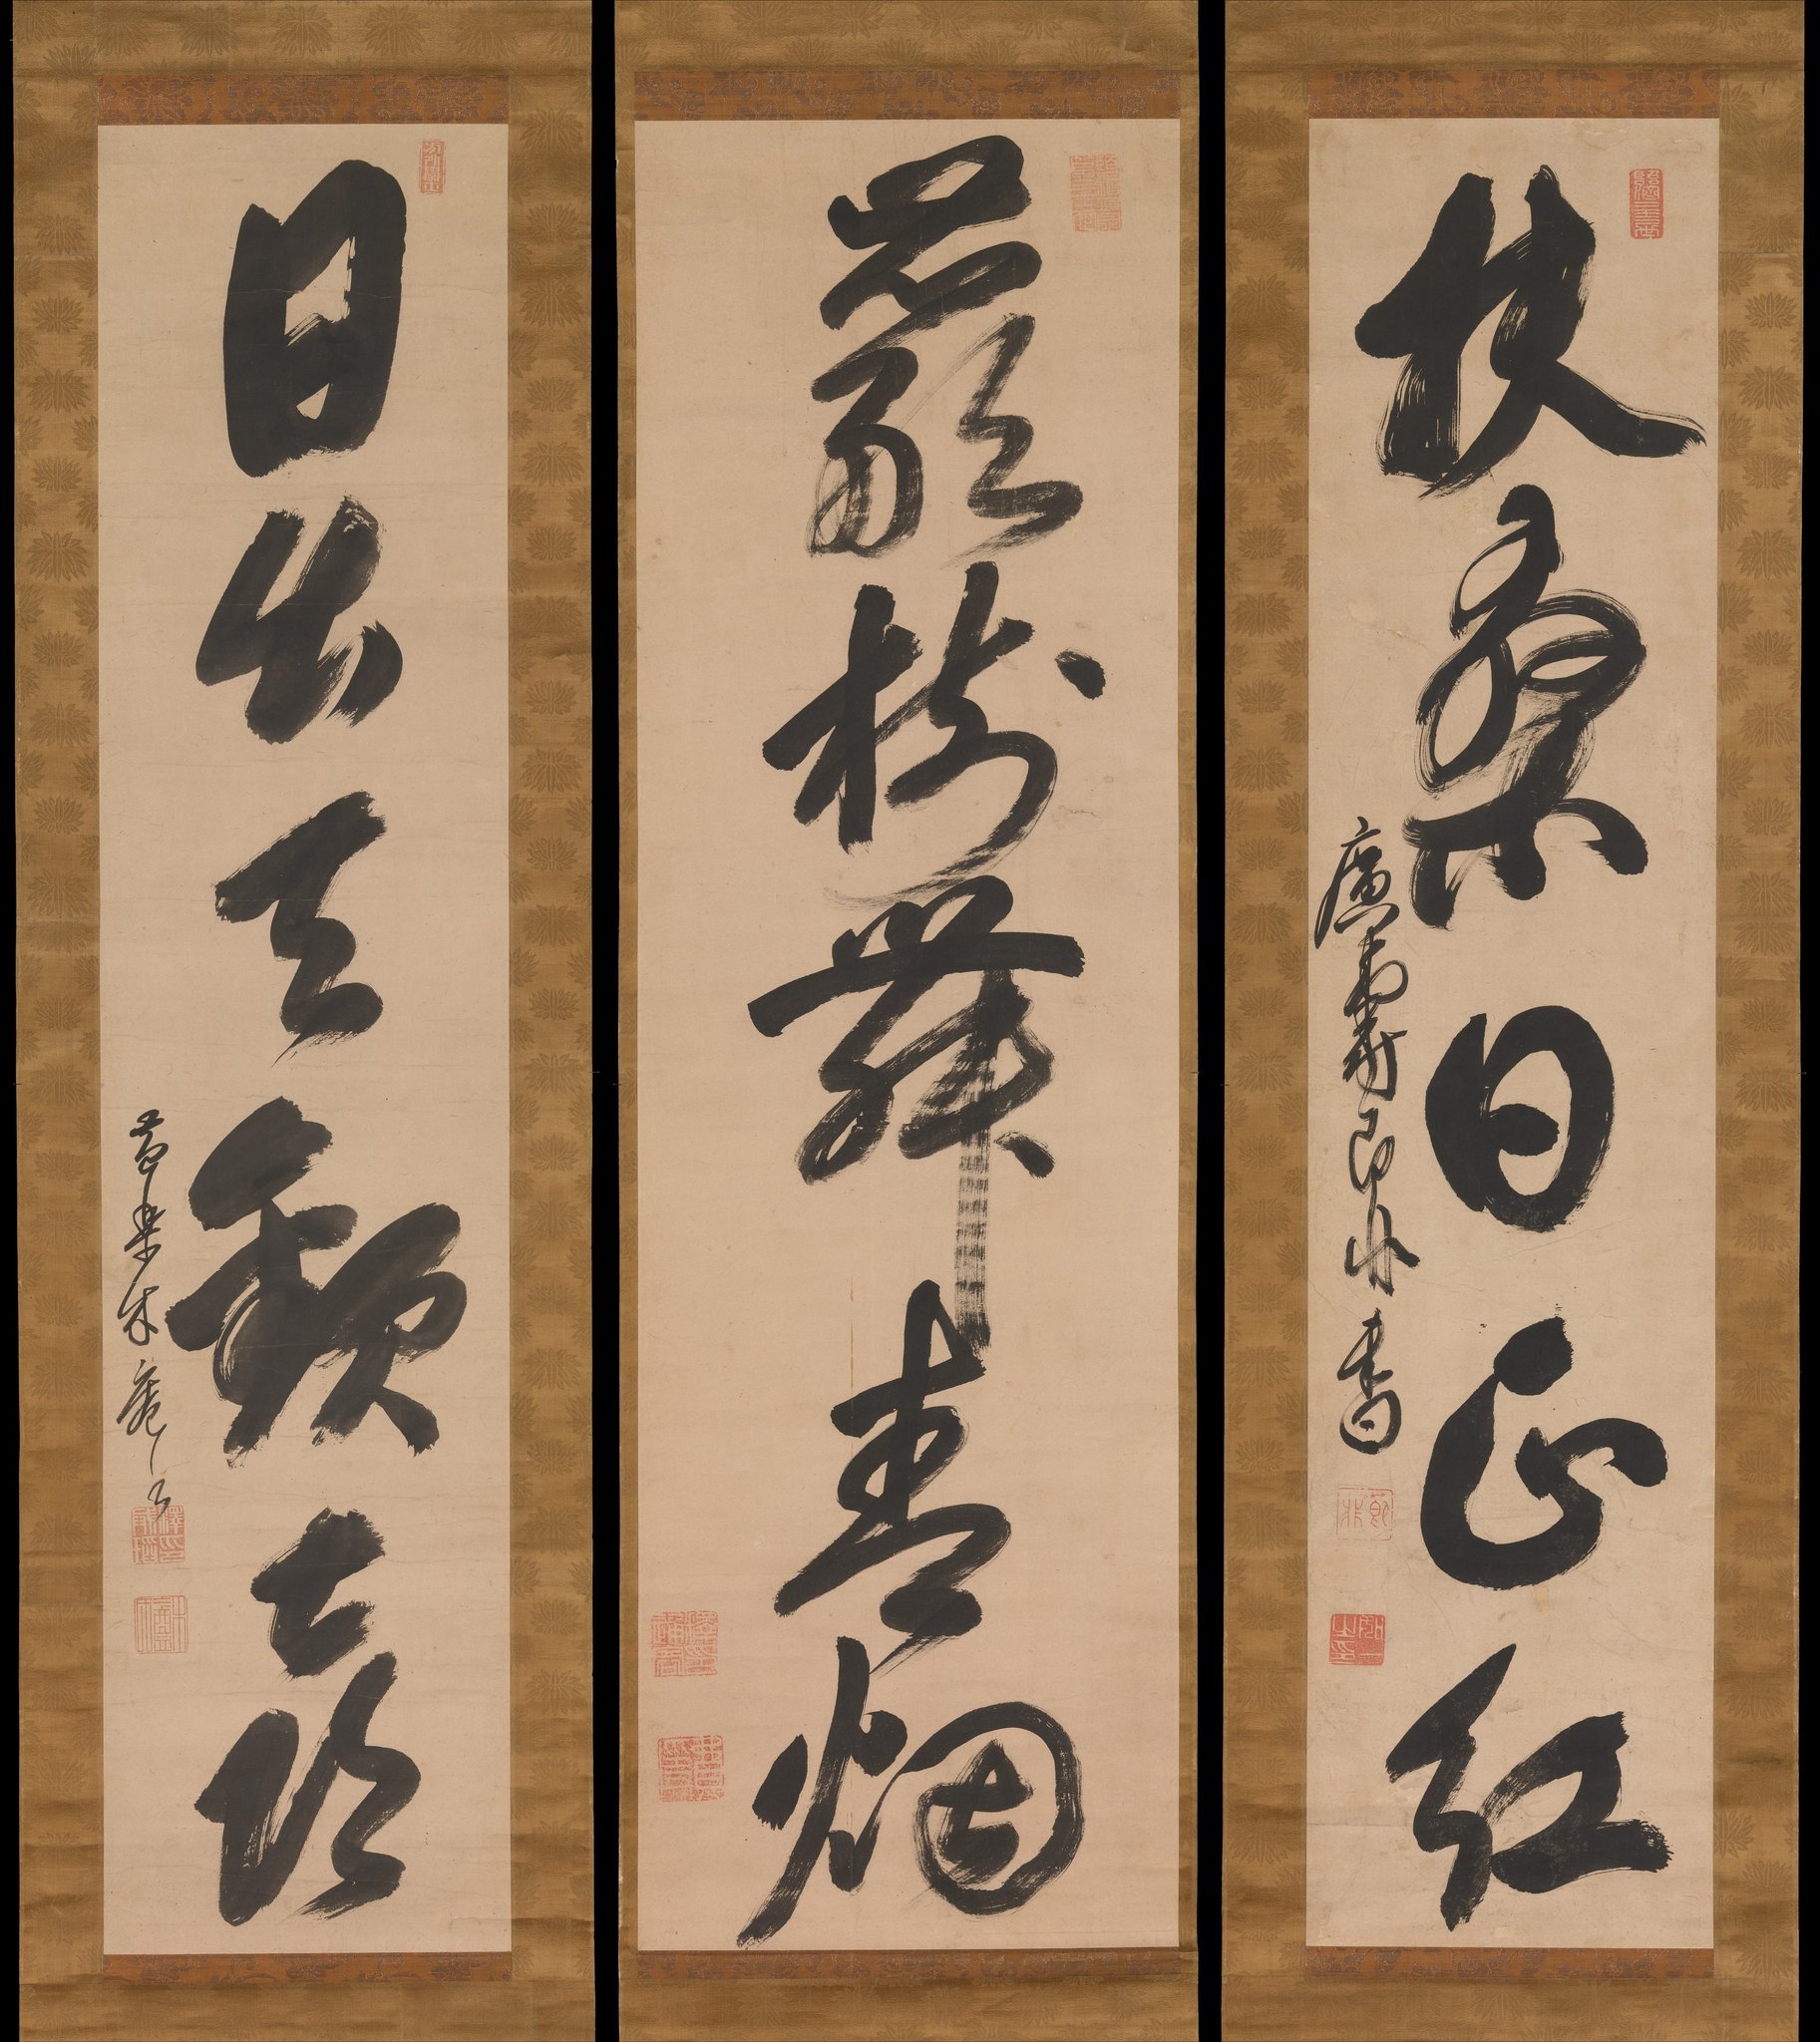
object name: hanging scroll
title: Poetic Phrases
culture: japanese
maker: mu'an xingtao (mokuan shōtō)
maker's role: artist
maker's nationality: chinese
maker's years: 1611-1684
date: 1601-1700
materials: ink, paper